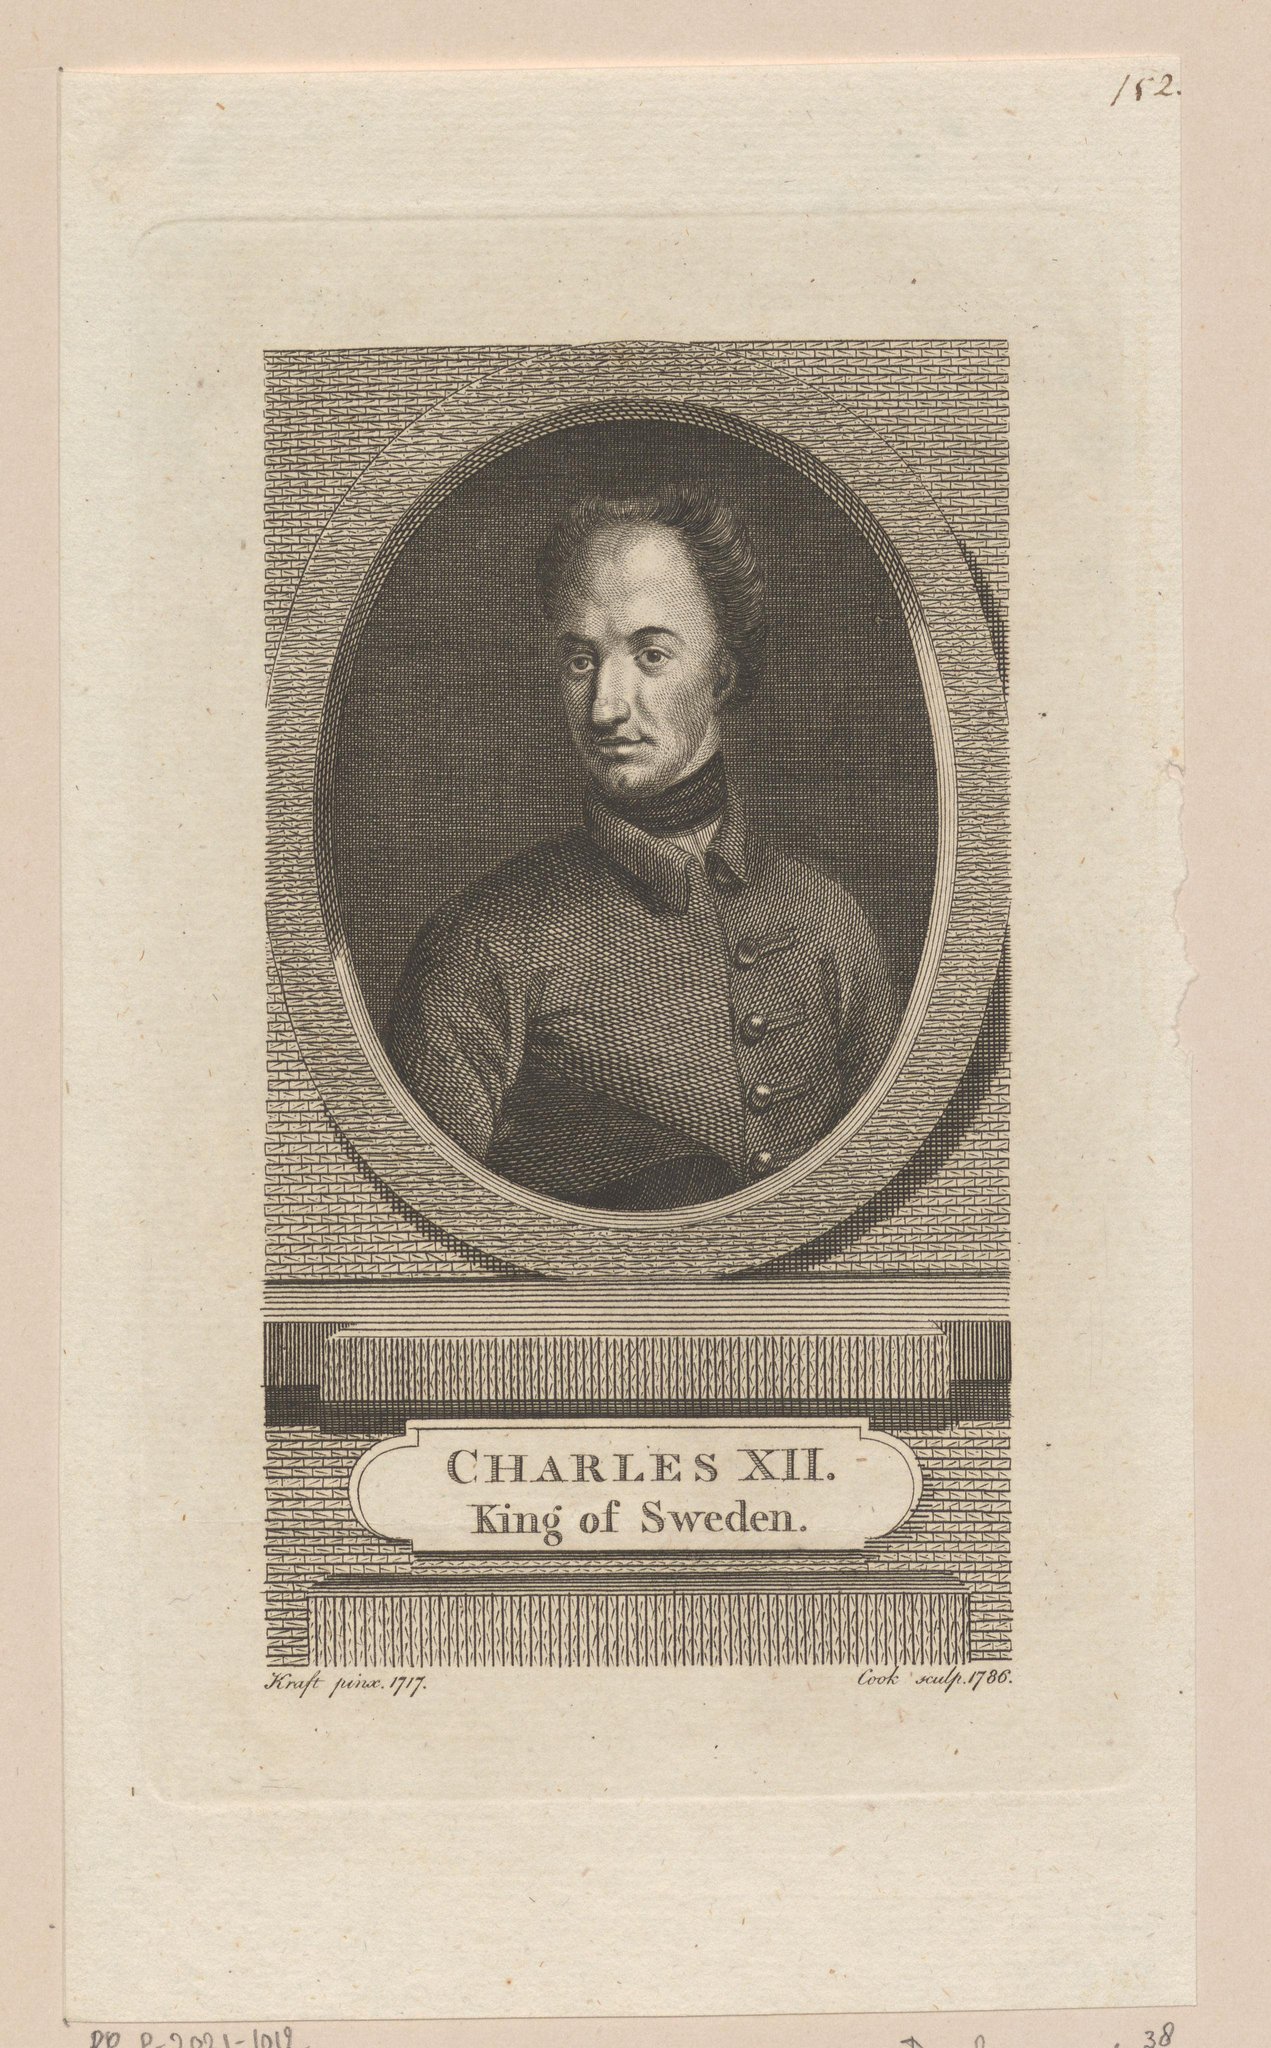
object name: print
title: Portret van Karel XII, koning van Zweden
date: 1786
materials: paper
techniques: engraving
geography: london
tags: historical persons, king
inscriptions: date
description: Prent mogelijk uit: The Universal Magazine of Knowledge and Pleasure, nr. 78-79, 1786.